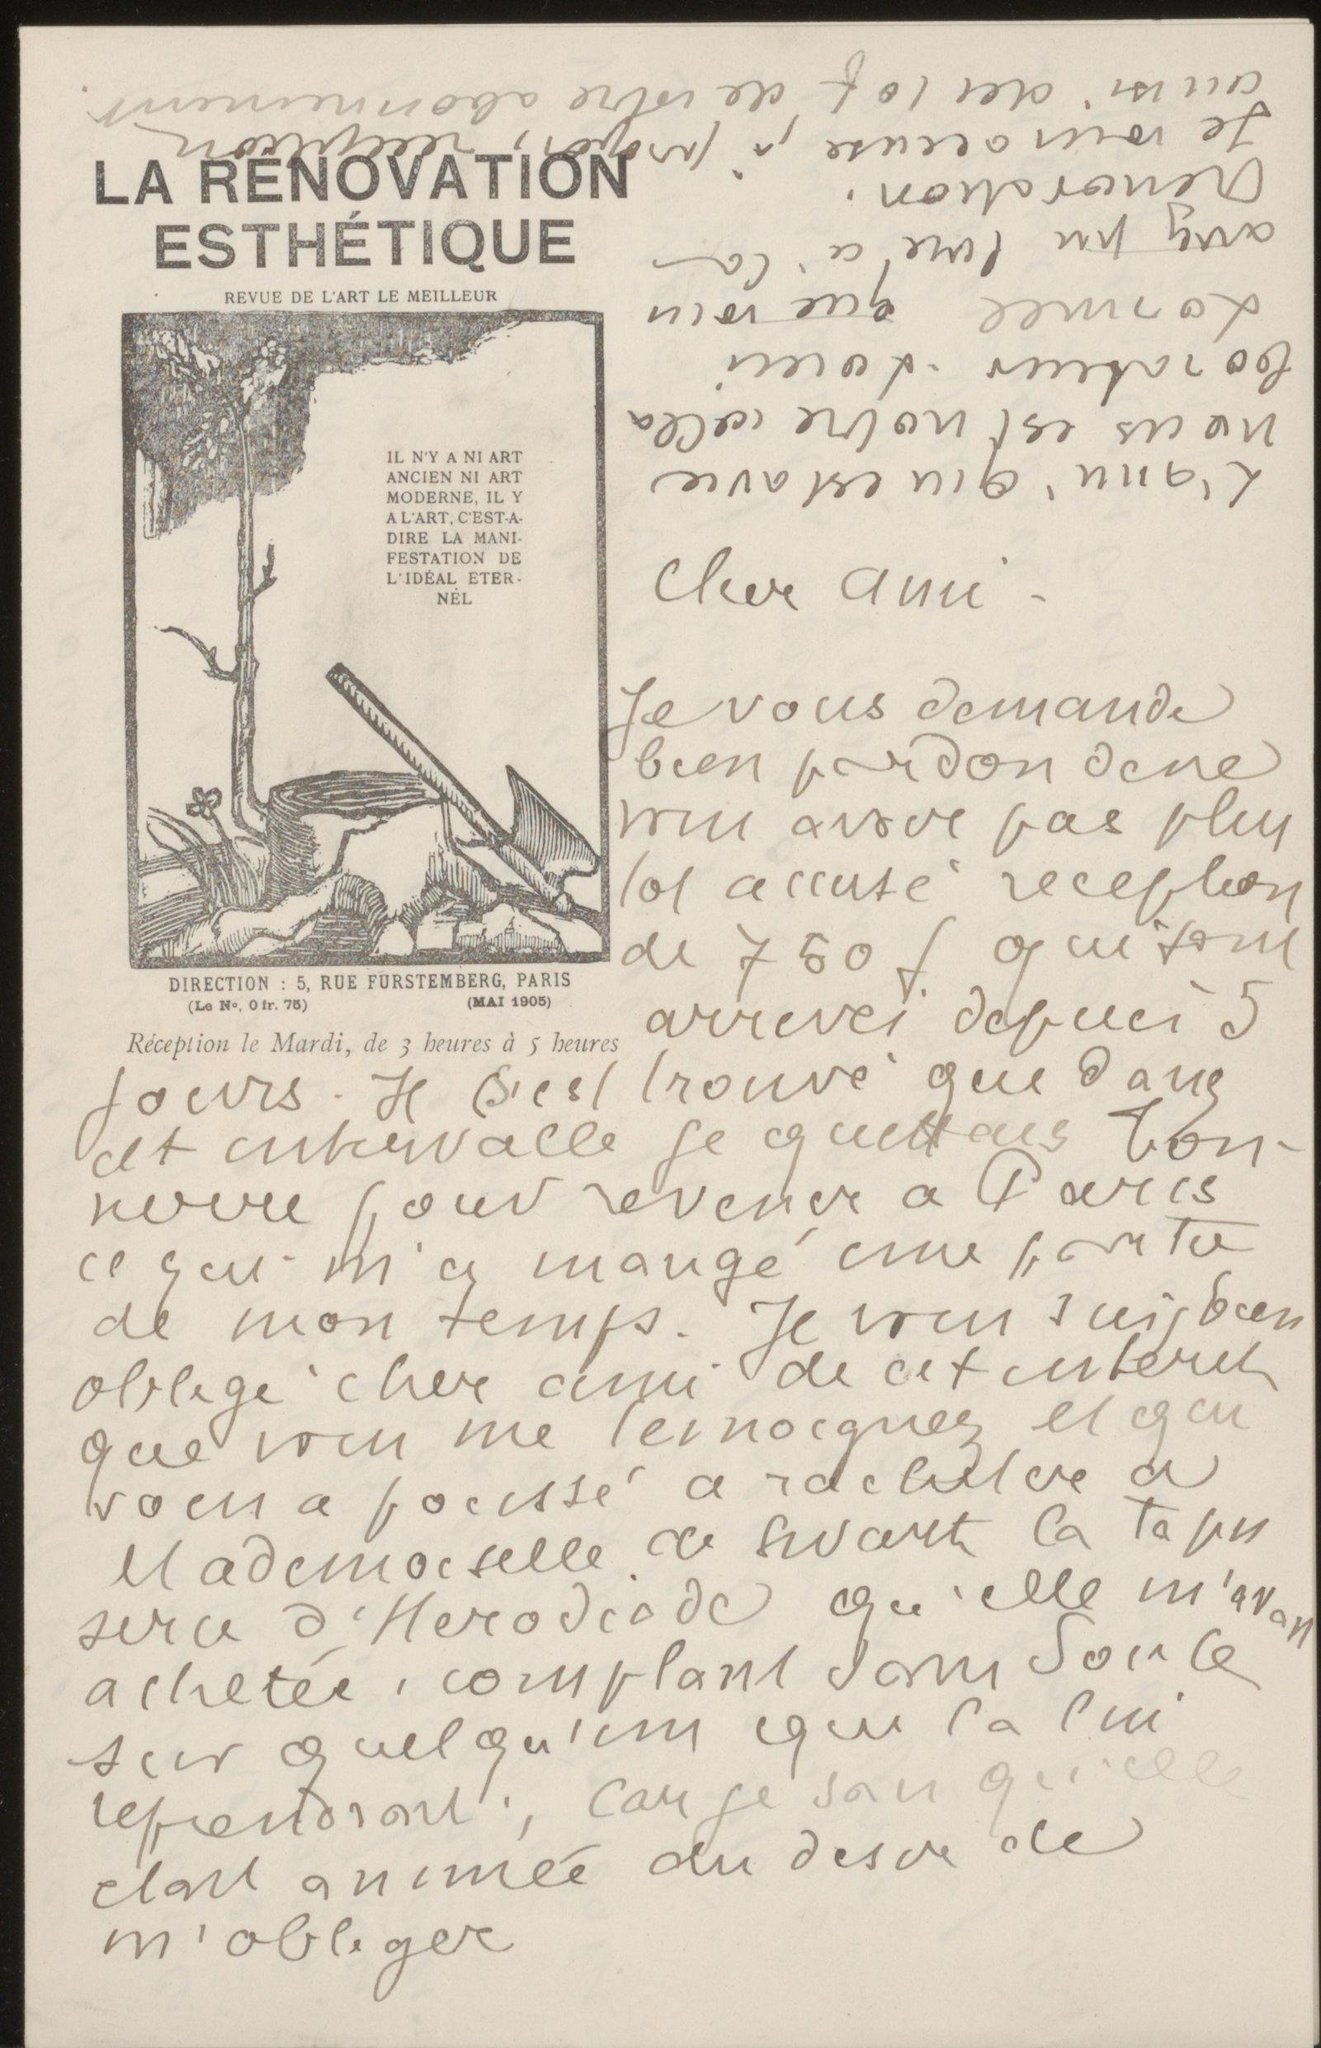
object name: letter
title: Brief aan Andries Bonger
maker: émile bernard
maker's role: print maker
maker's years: 1868-1941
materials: ink, paper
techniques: pen, printing, writing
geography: paris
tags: amsterdam, andries bonger, arnhem, sculptor, saar de swart, drawing, applied arts, arts and crafts; industrial design, music, travelling; tourism, historical persons (portraits and scenes from the life), money, italy, paris, rome